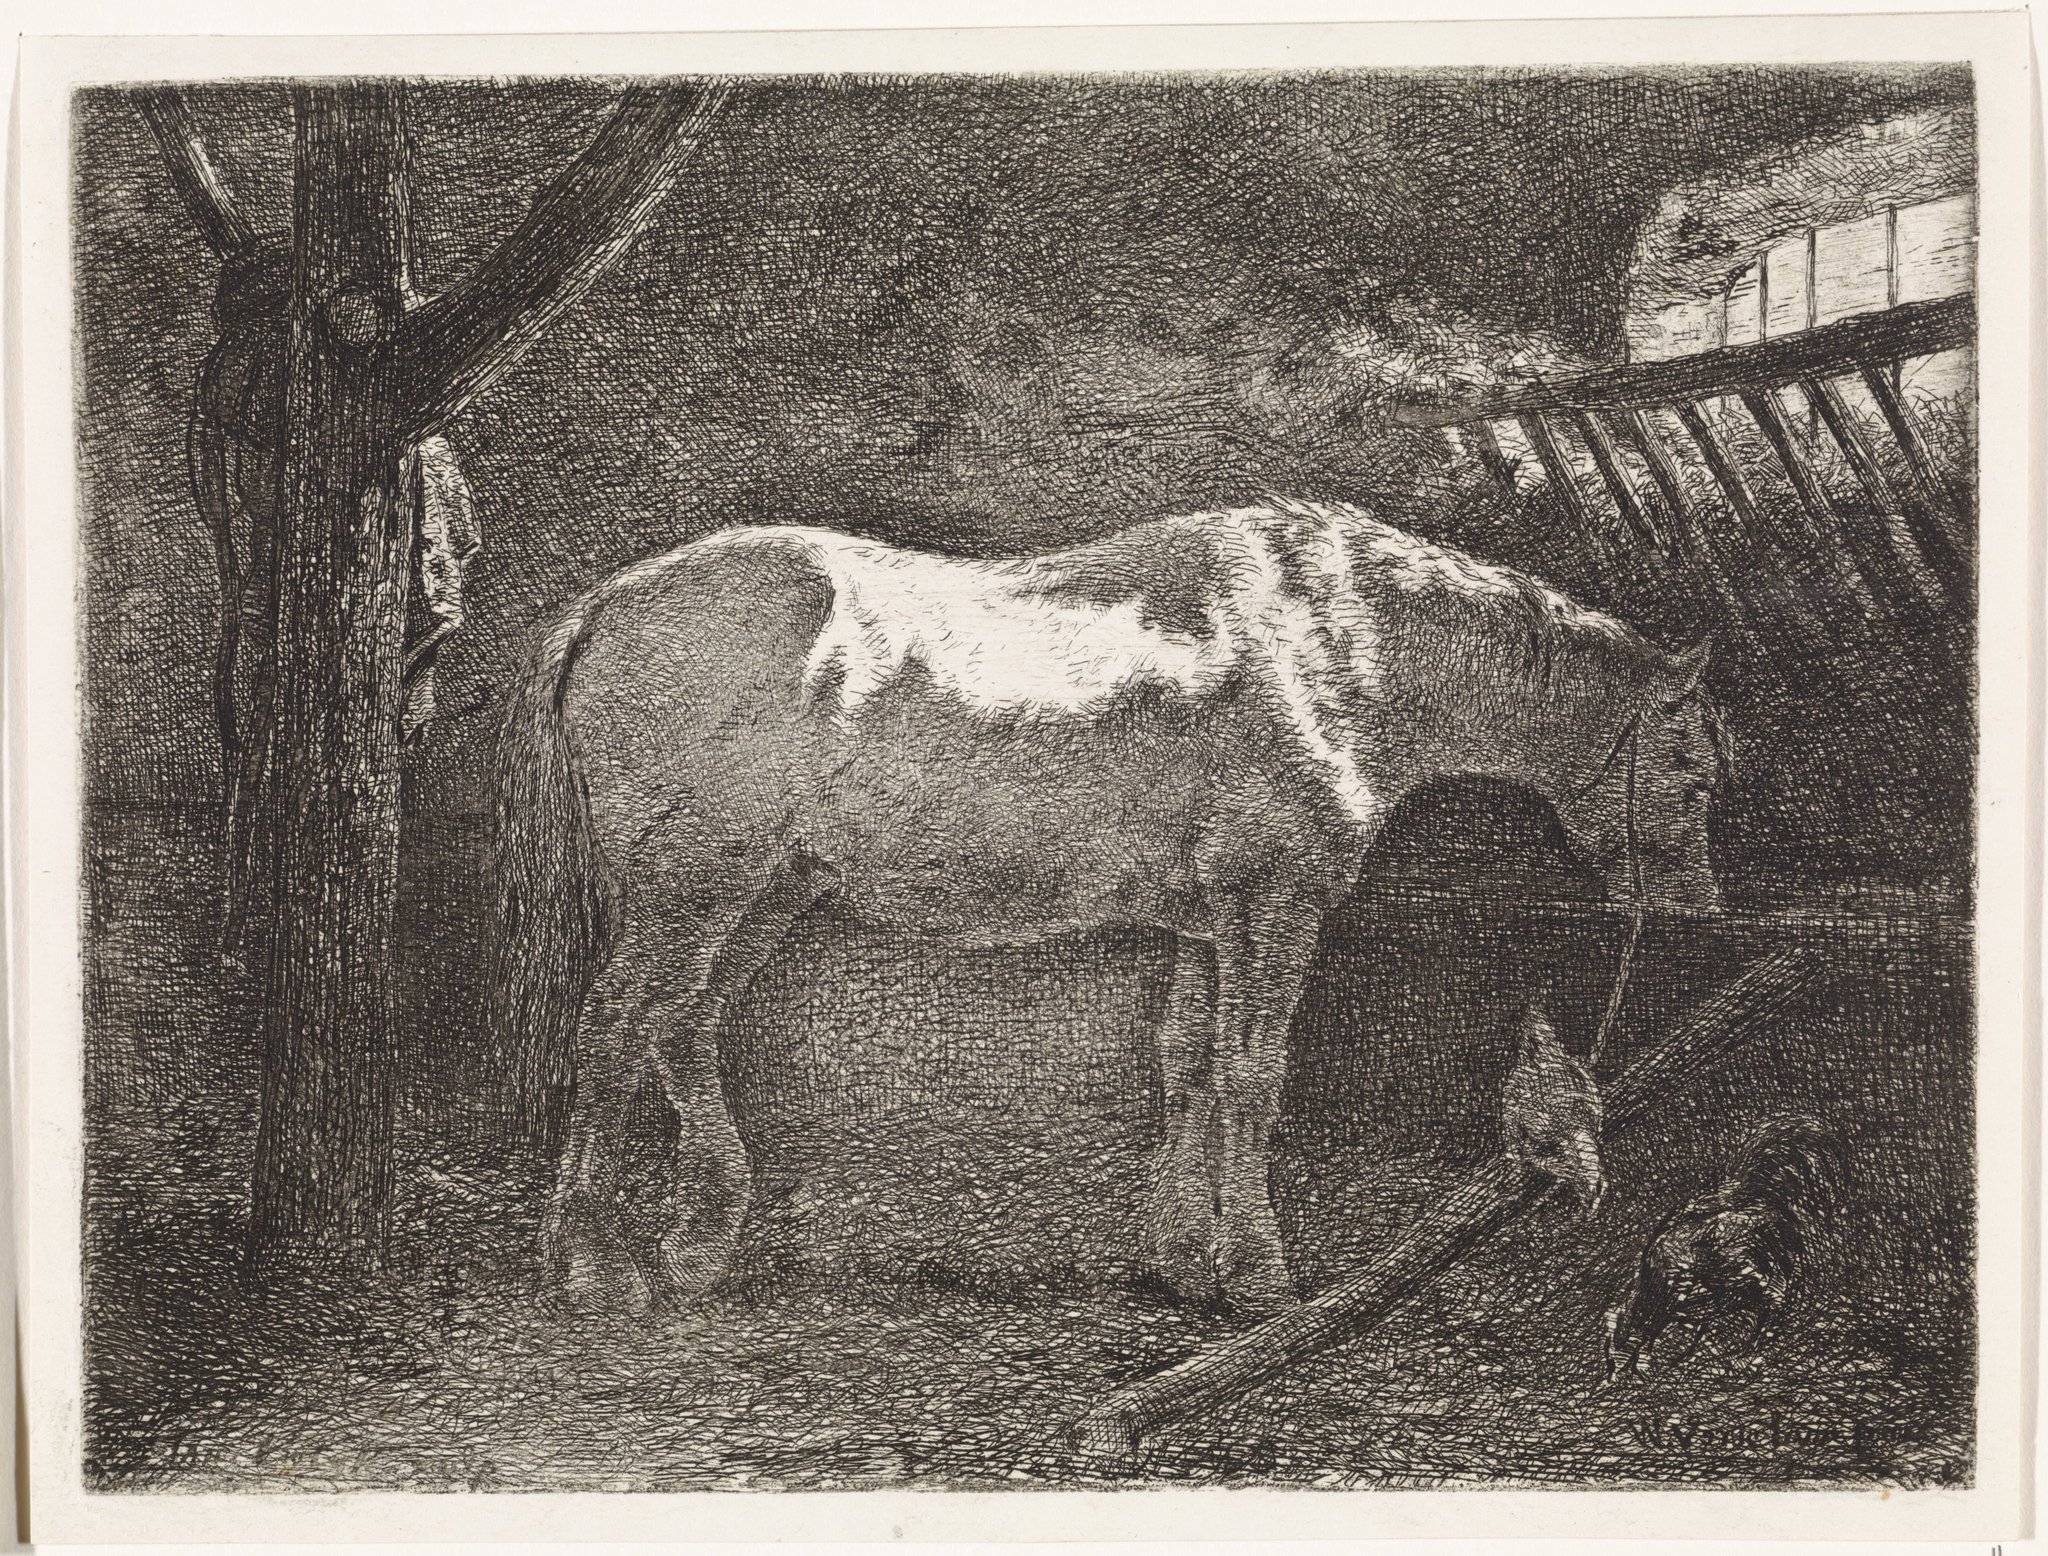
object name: print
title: Paard in stal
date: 1860-1894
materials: paper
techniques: etching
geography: the hague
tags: horses and kindred animals, fowl (cock, hen, chicken, etc.), stall, stable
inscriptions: collector's mark: Lugt 2228